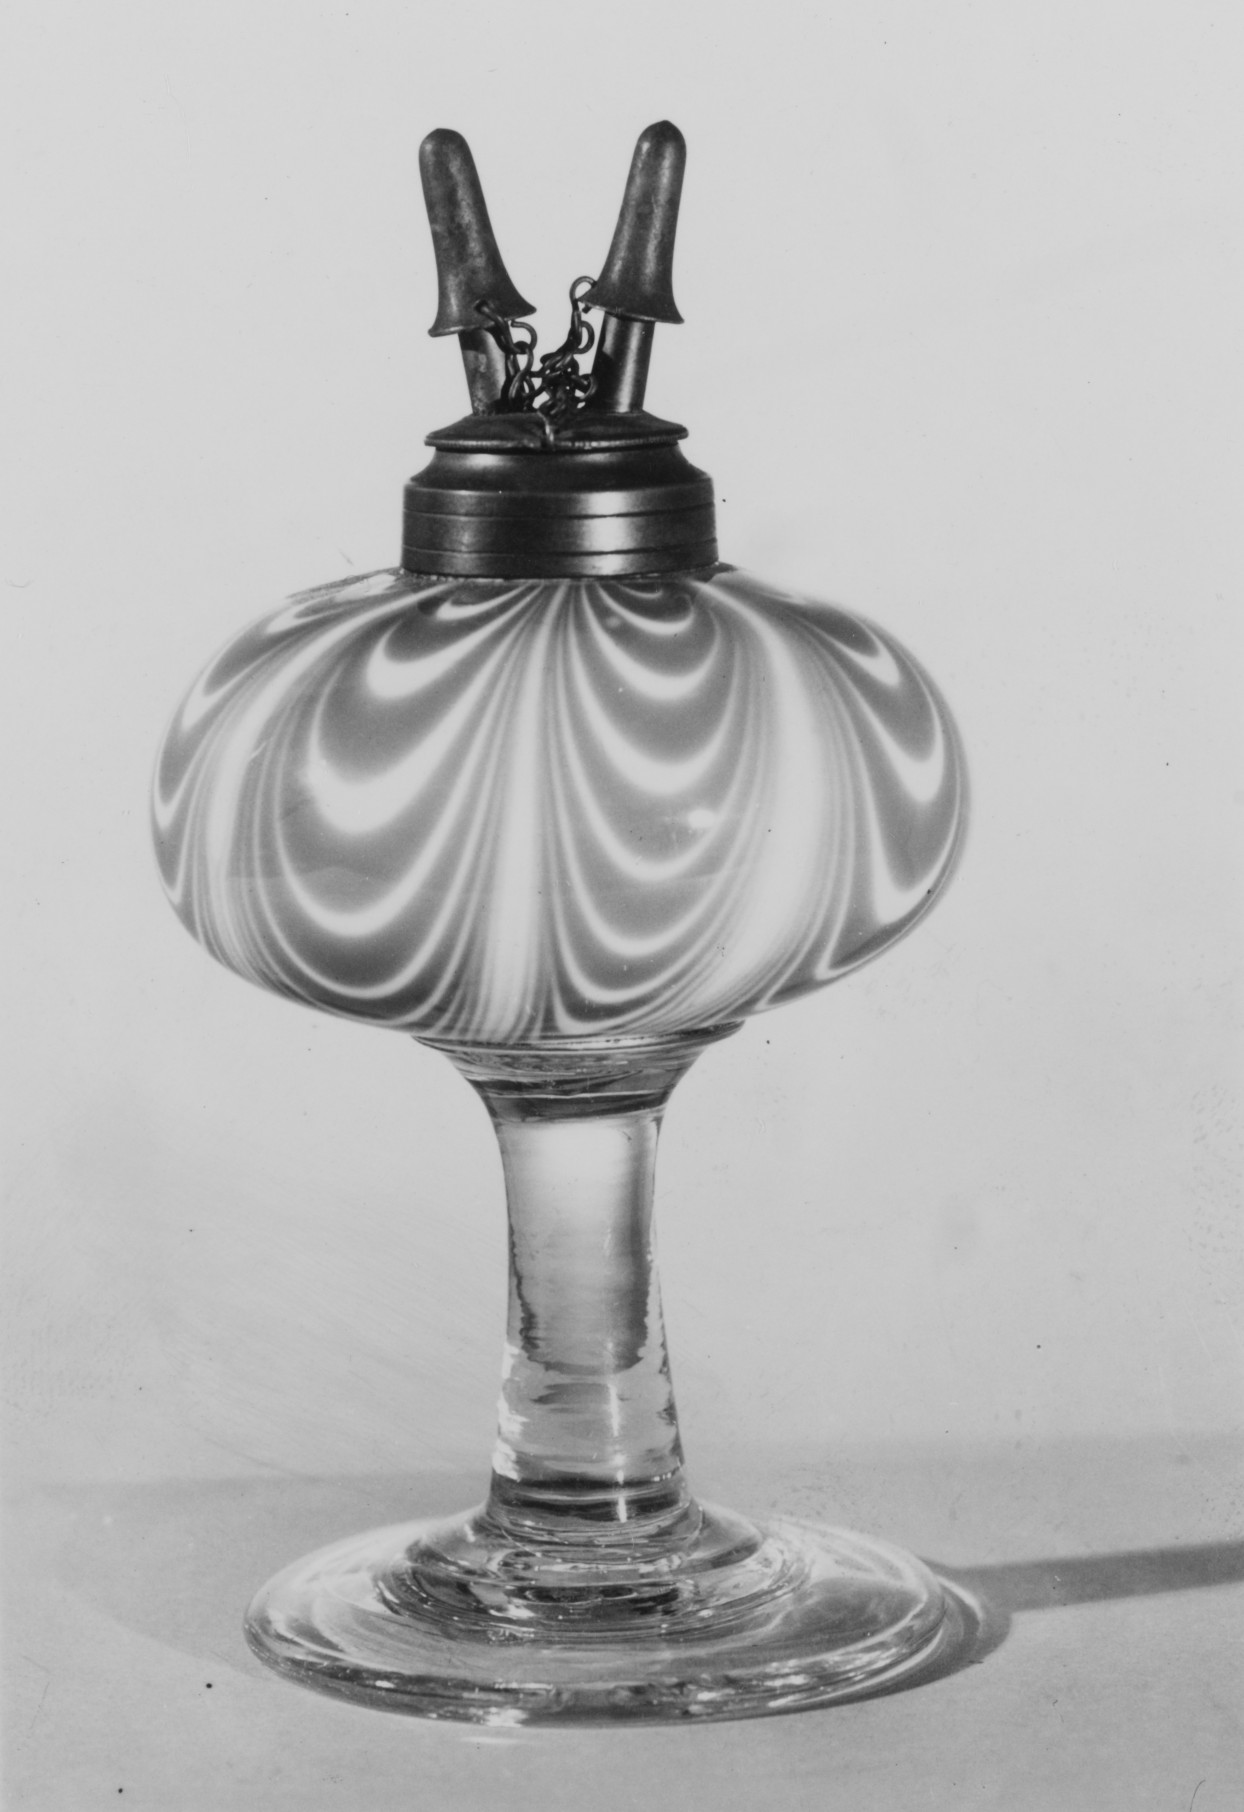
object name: lamp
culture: american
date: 1801-1900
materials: brass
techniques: glassblowing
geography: united states